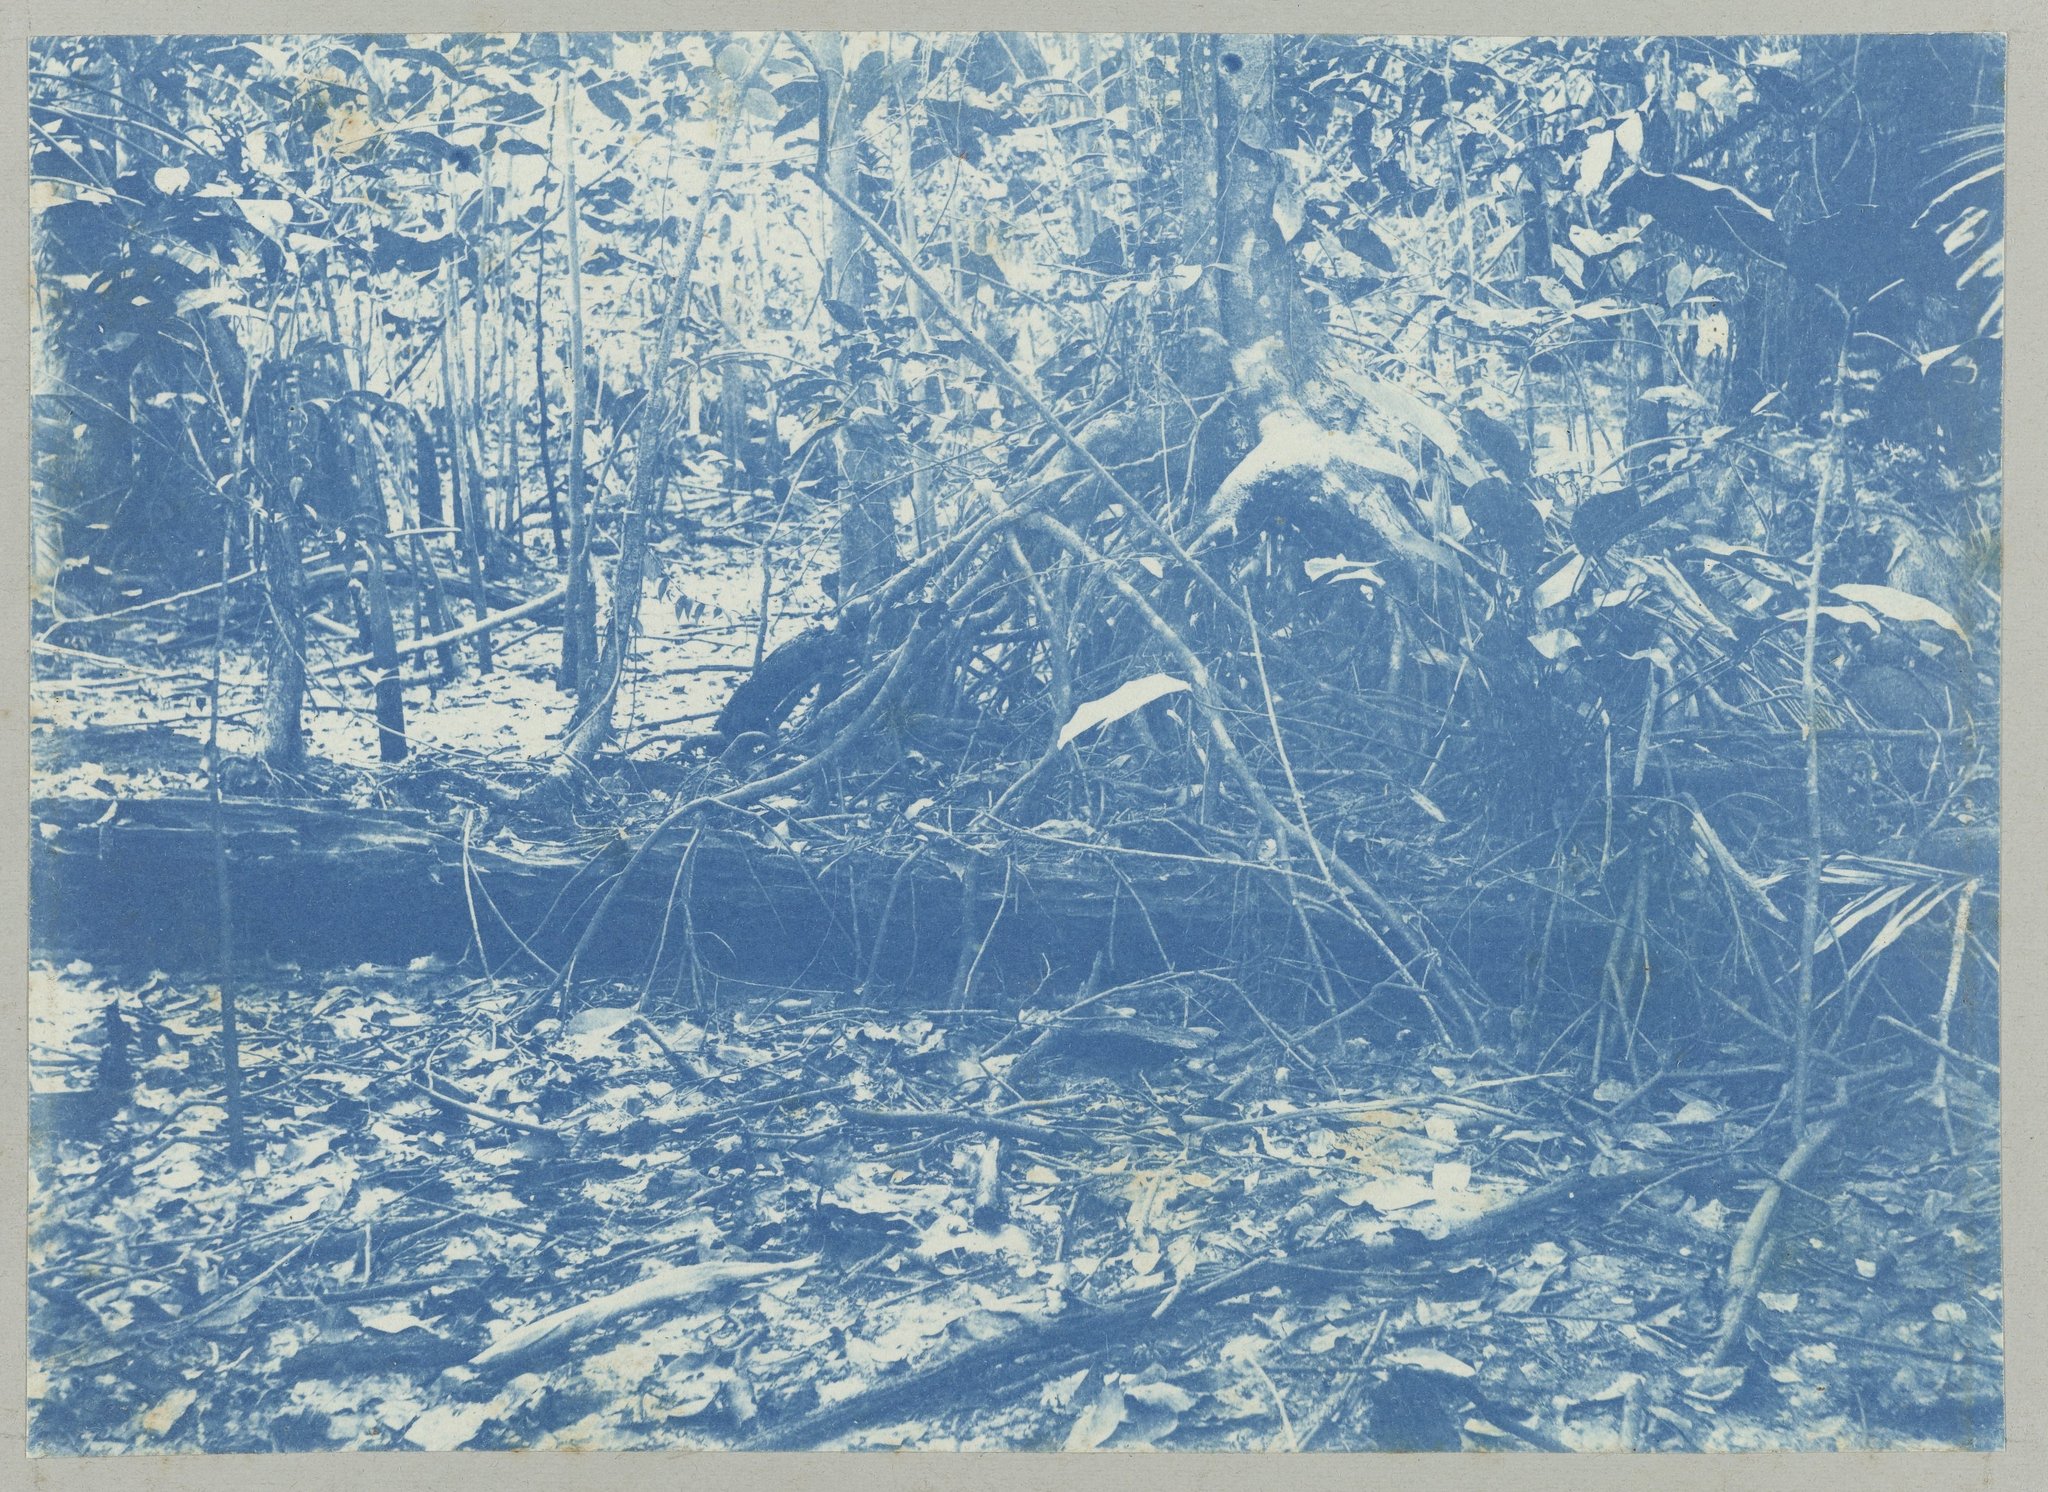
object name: photograph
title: Droog zwamp achter "Ma retraite"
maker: hendrik doijer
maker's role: engineer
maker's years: 1863-1925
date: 1903-1910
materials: photographic support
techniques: cyanotype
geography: suriname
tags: suriname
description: Droogevallen moeras op het terrein achter de plantage Ma Retraite. Onderdeel van het fotoalbum Souvenir de Voyage (deel 1), over het leven van de familie Doijer in en rond de plantage Ma Retraite in Suriname in de jaren 1903-1910.